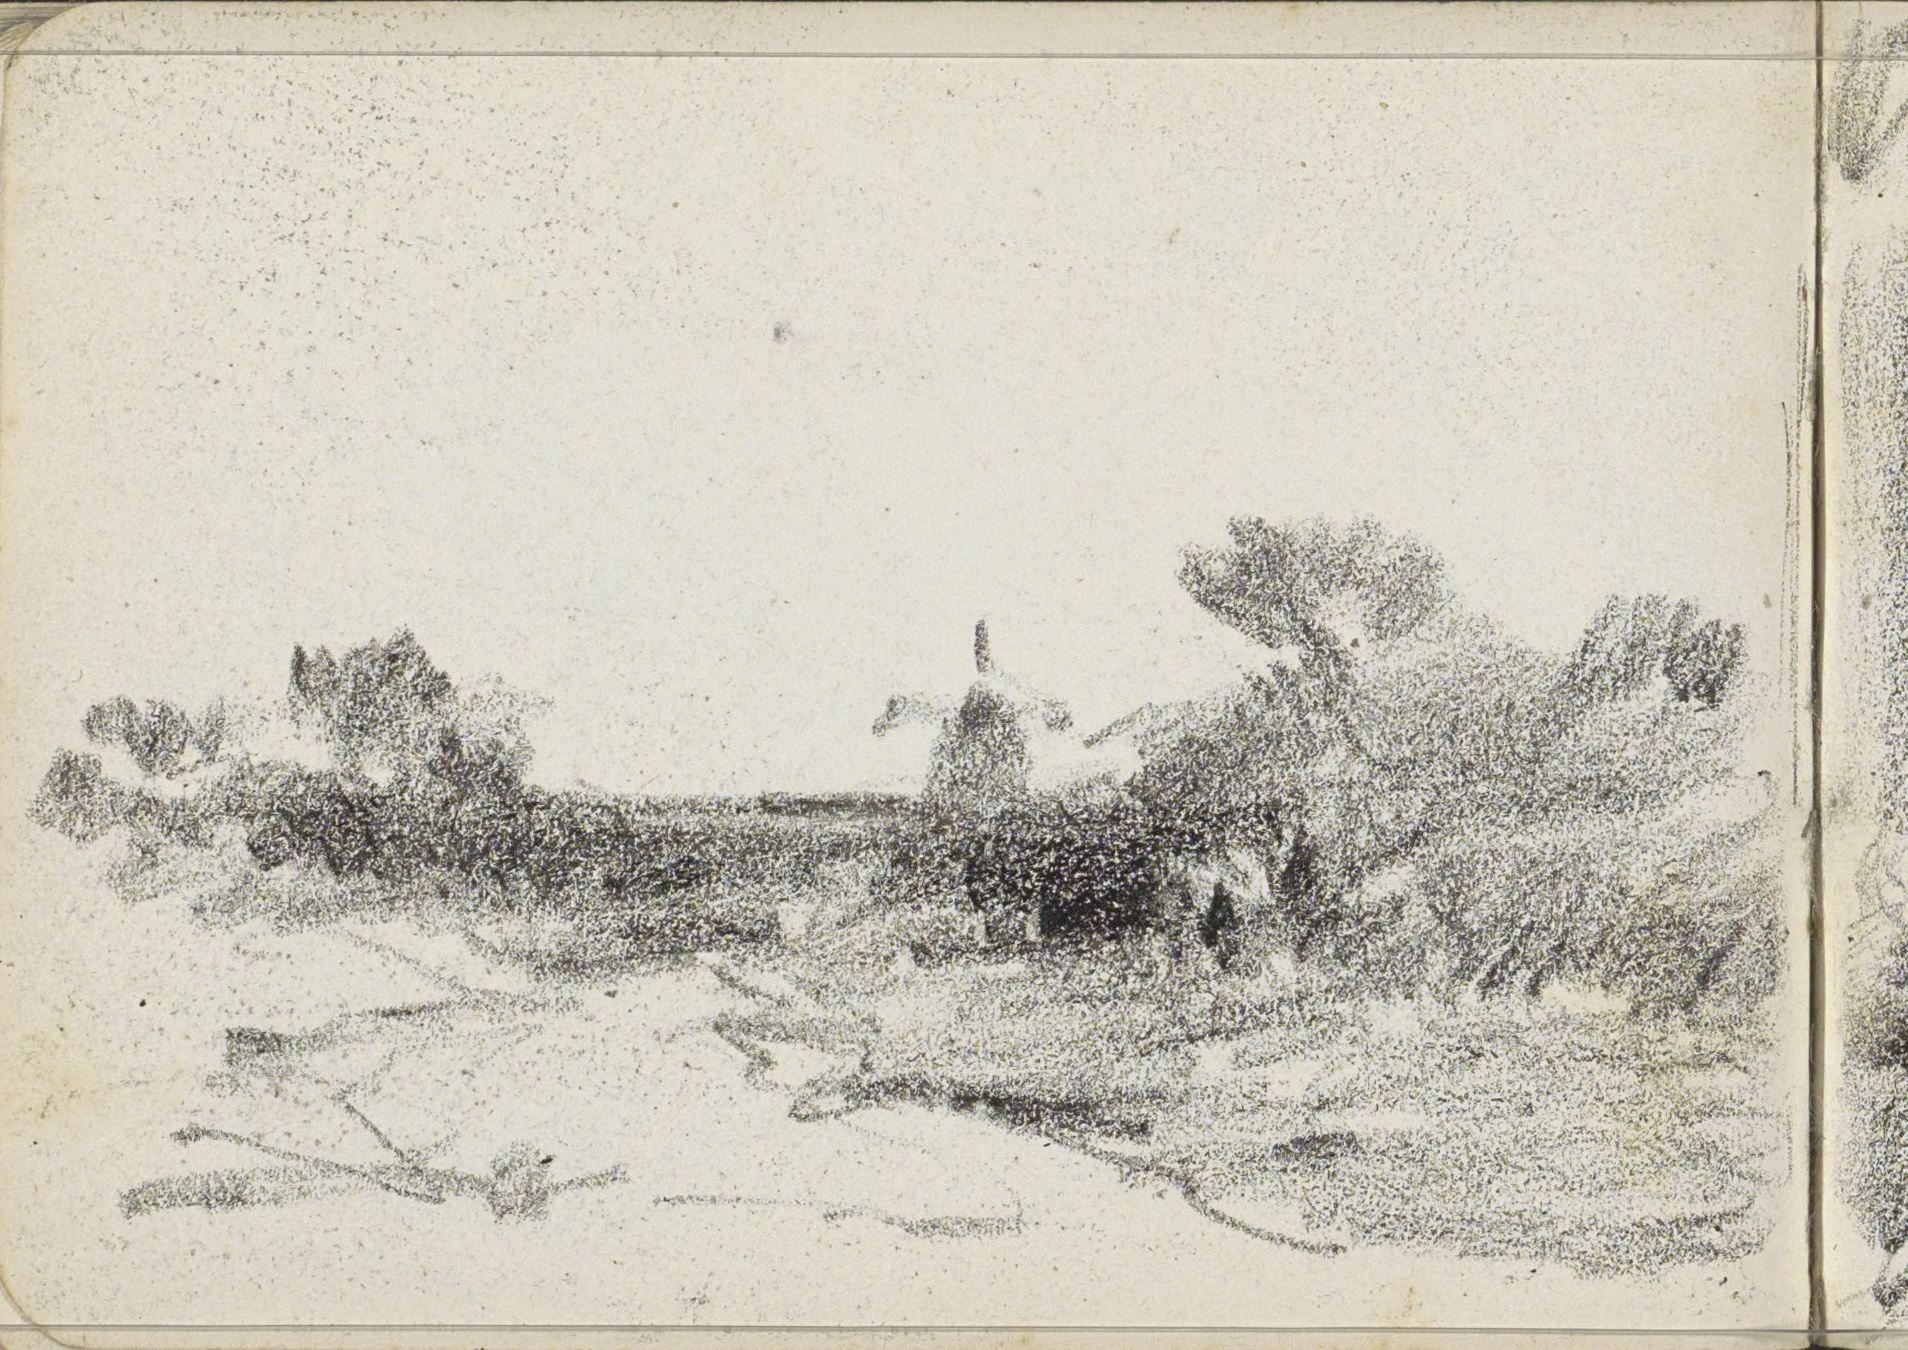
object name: sketchbook leaf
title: Landschap met een molen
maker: willem cornelis rip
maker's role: draughtsman, painter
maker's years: 1856-1922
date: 1907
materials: chalk, paper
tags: windmill in landscape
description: Blad 30 verso uit een schetsboek met 41 bladen.